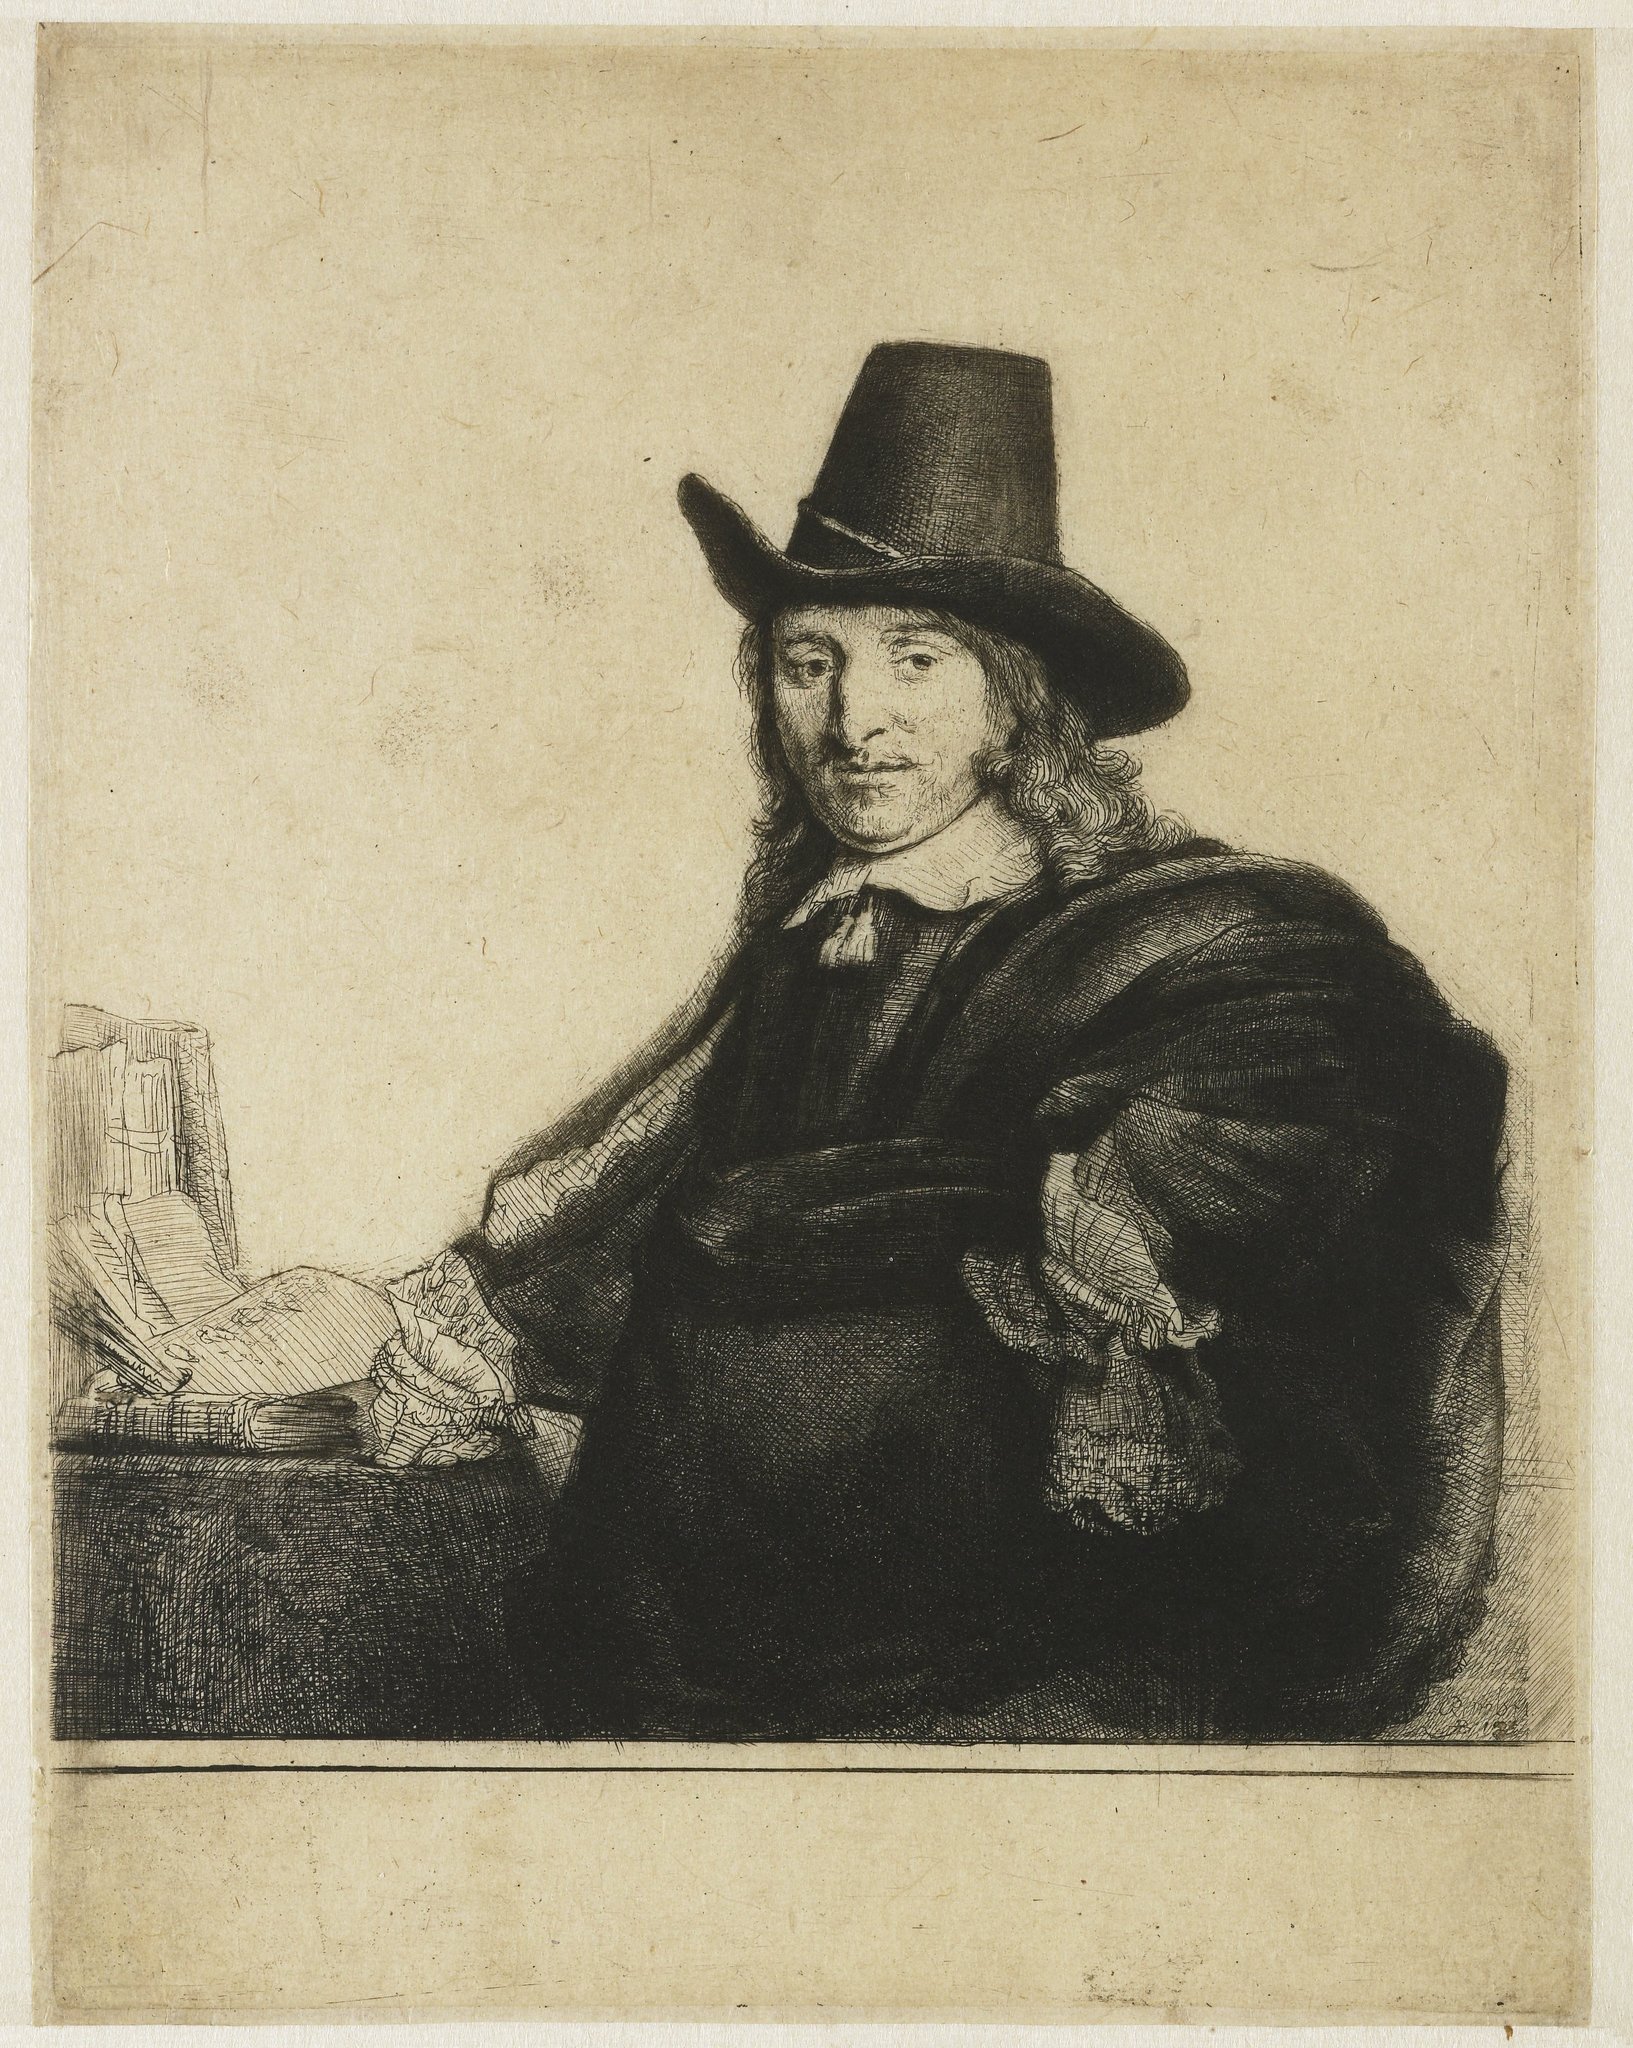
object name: print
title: Jan Asselijn, painter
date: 1647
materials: paper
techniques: drypoint, etching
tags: jan asselijn, portrait, self-portrait of painter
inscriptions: collector's mark: Lugt 272, signature and date: ‘Rembr / f 16’, collector's mark: Lugt 2228